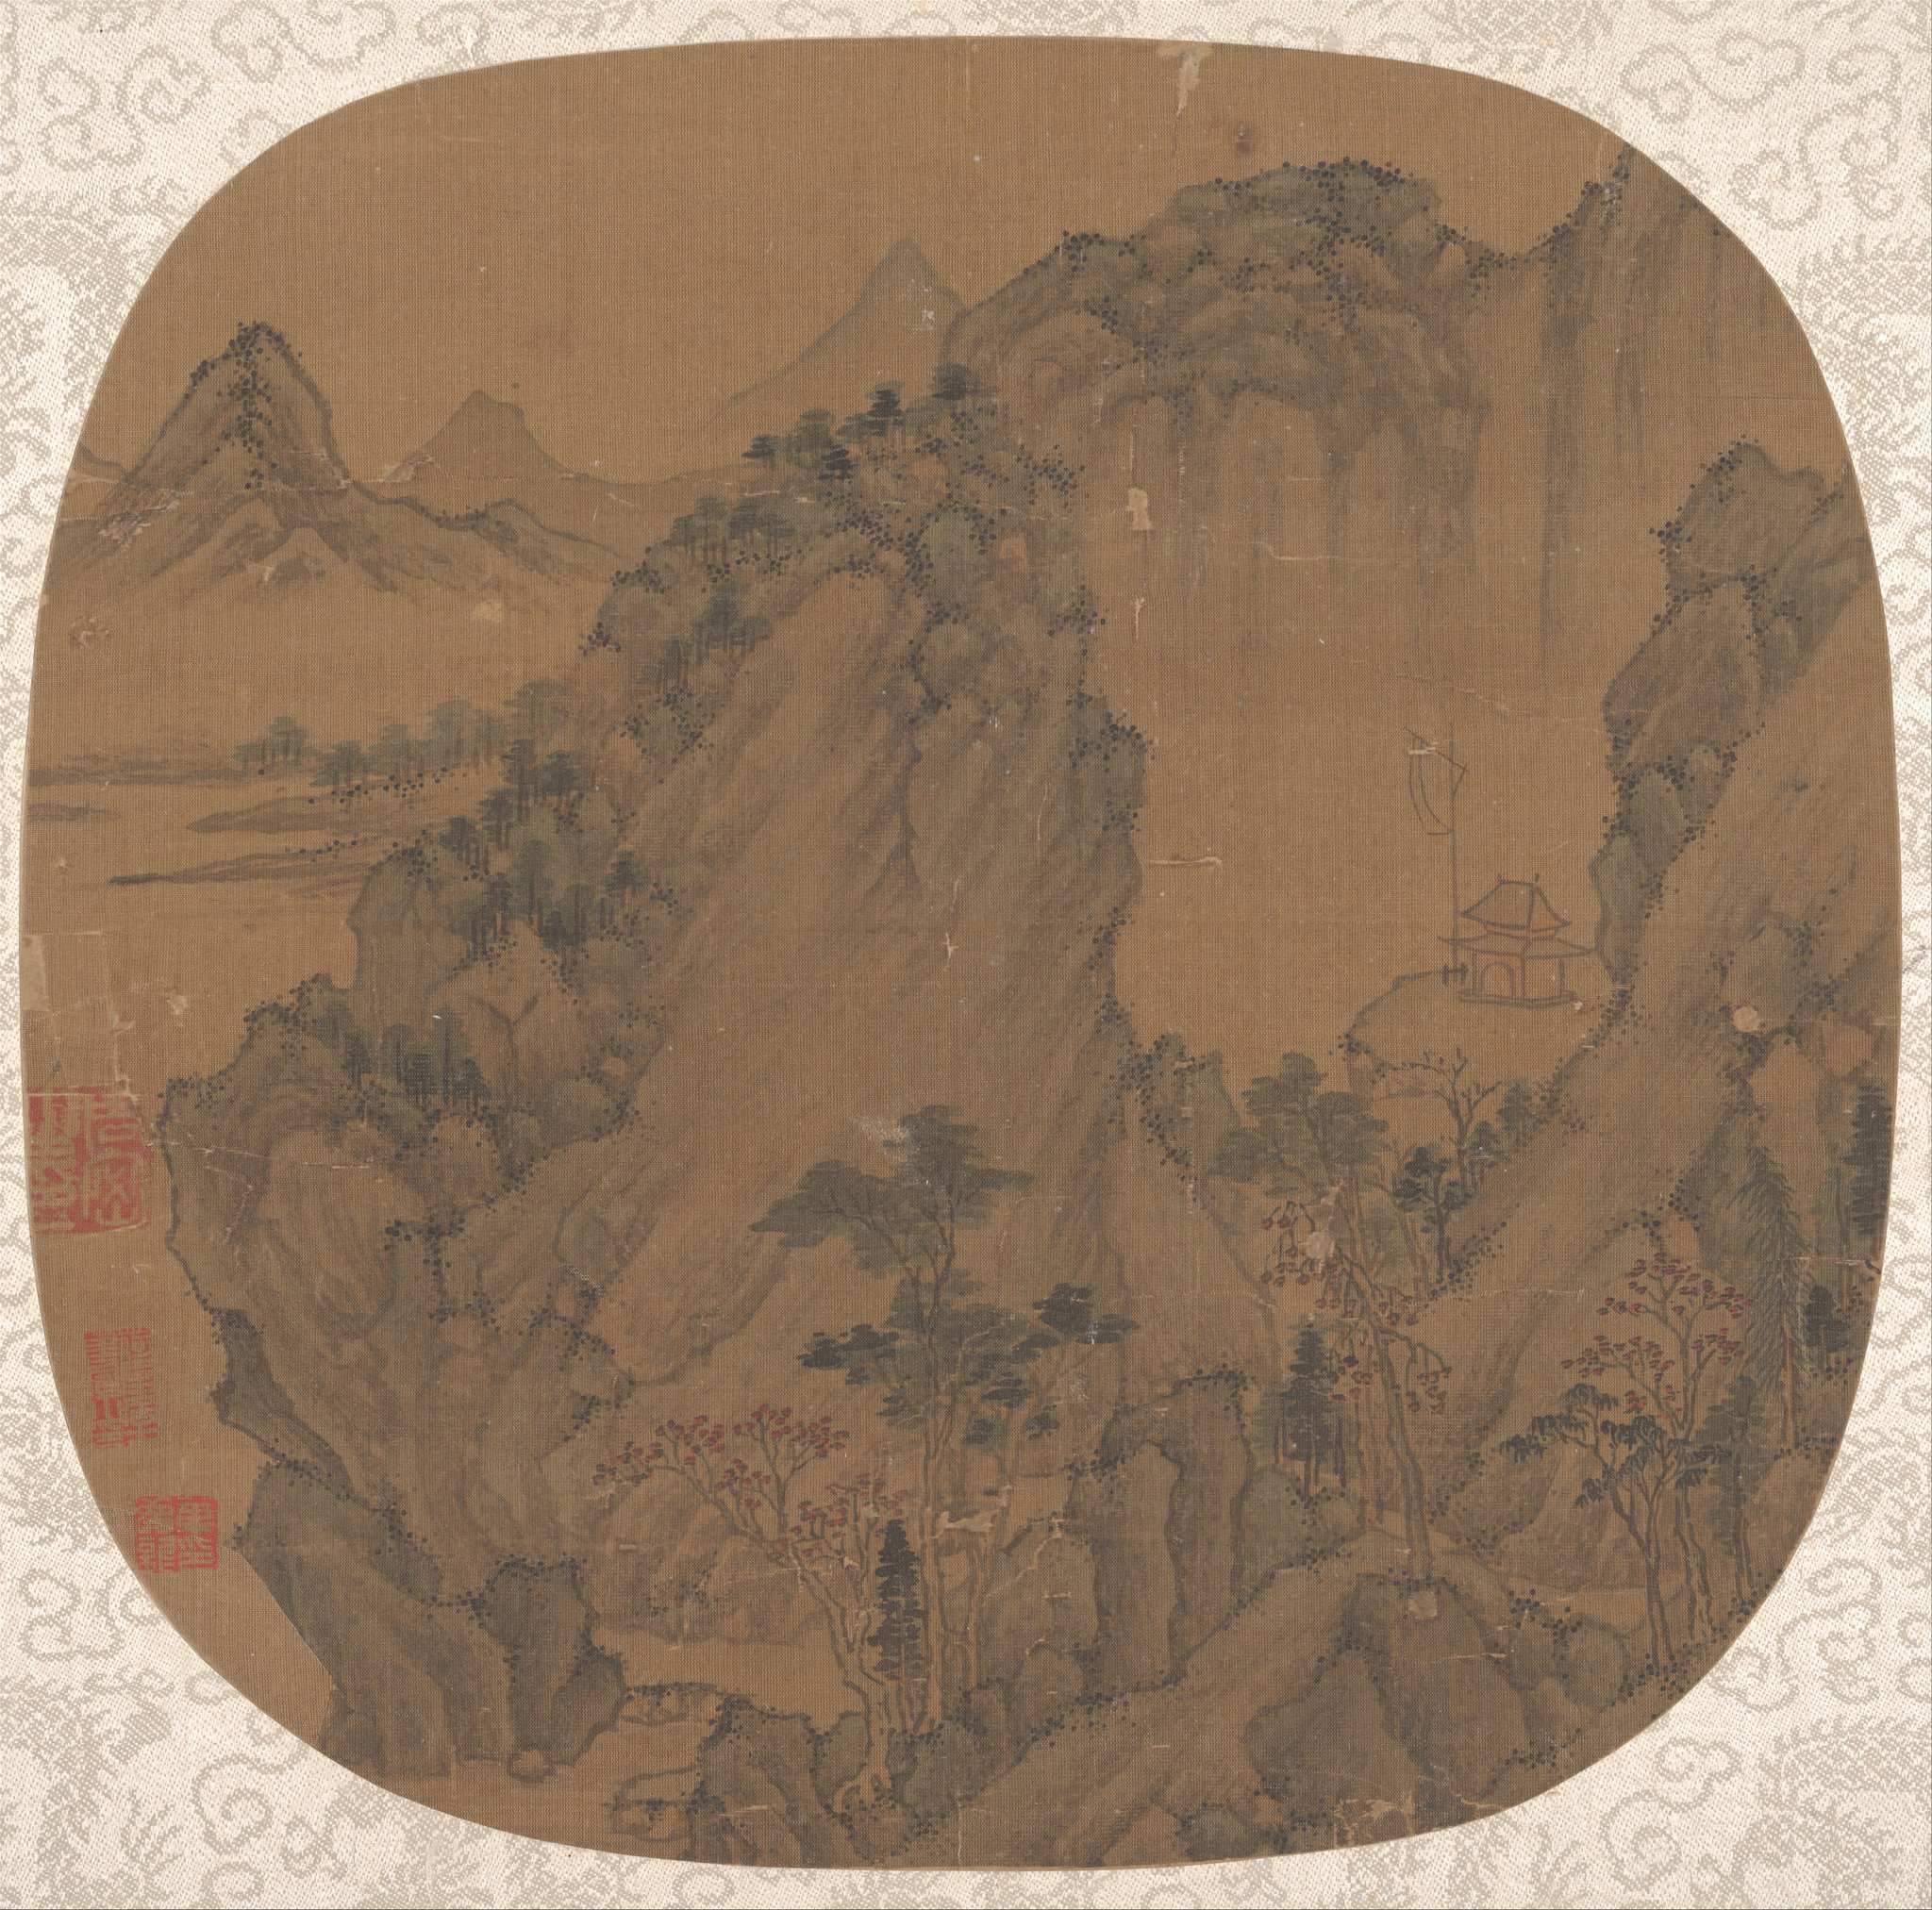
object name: fan mounted a an album leaf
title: Autumnal Hills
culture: chinese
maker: unidentified artist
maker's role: artist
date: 1368-1911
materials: ink, silk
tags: mountains,landscapes